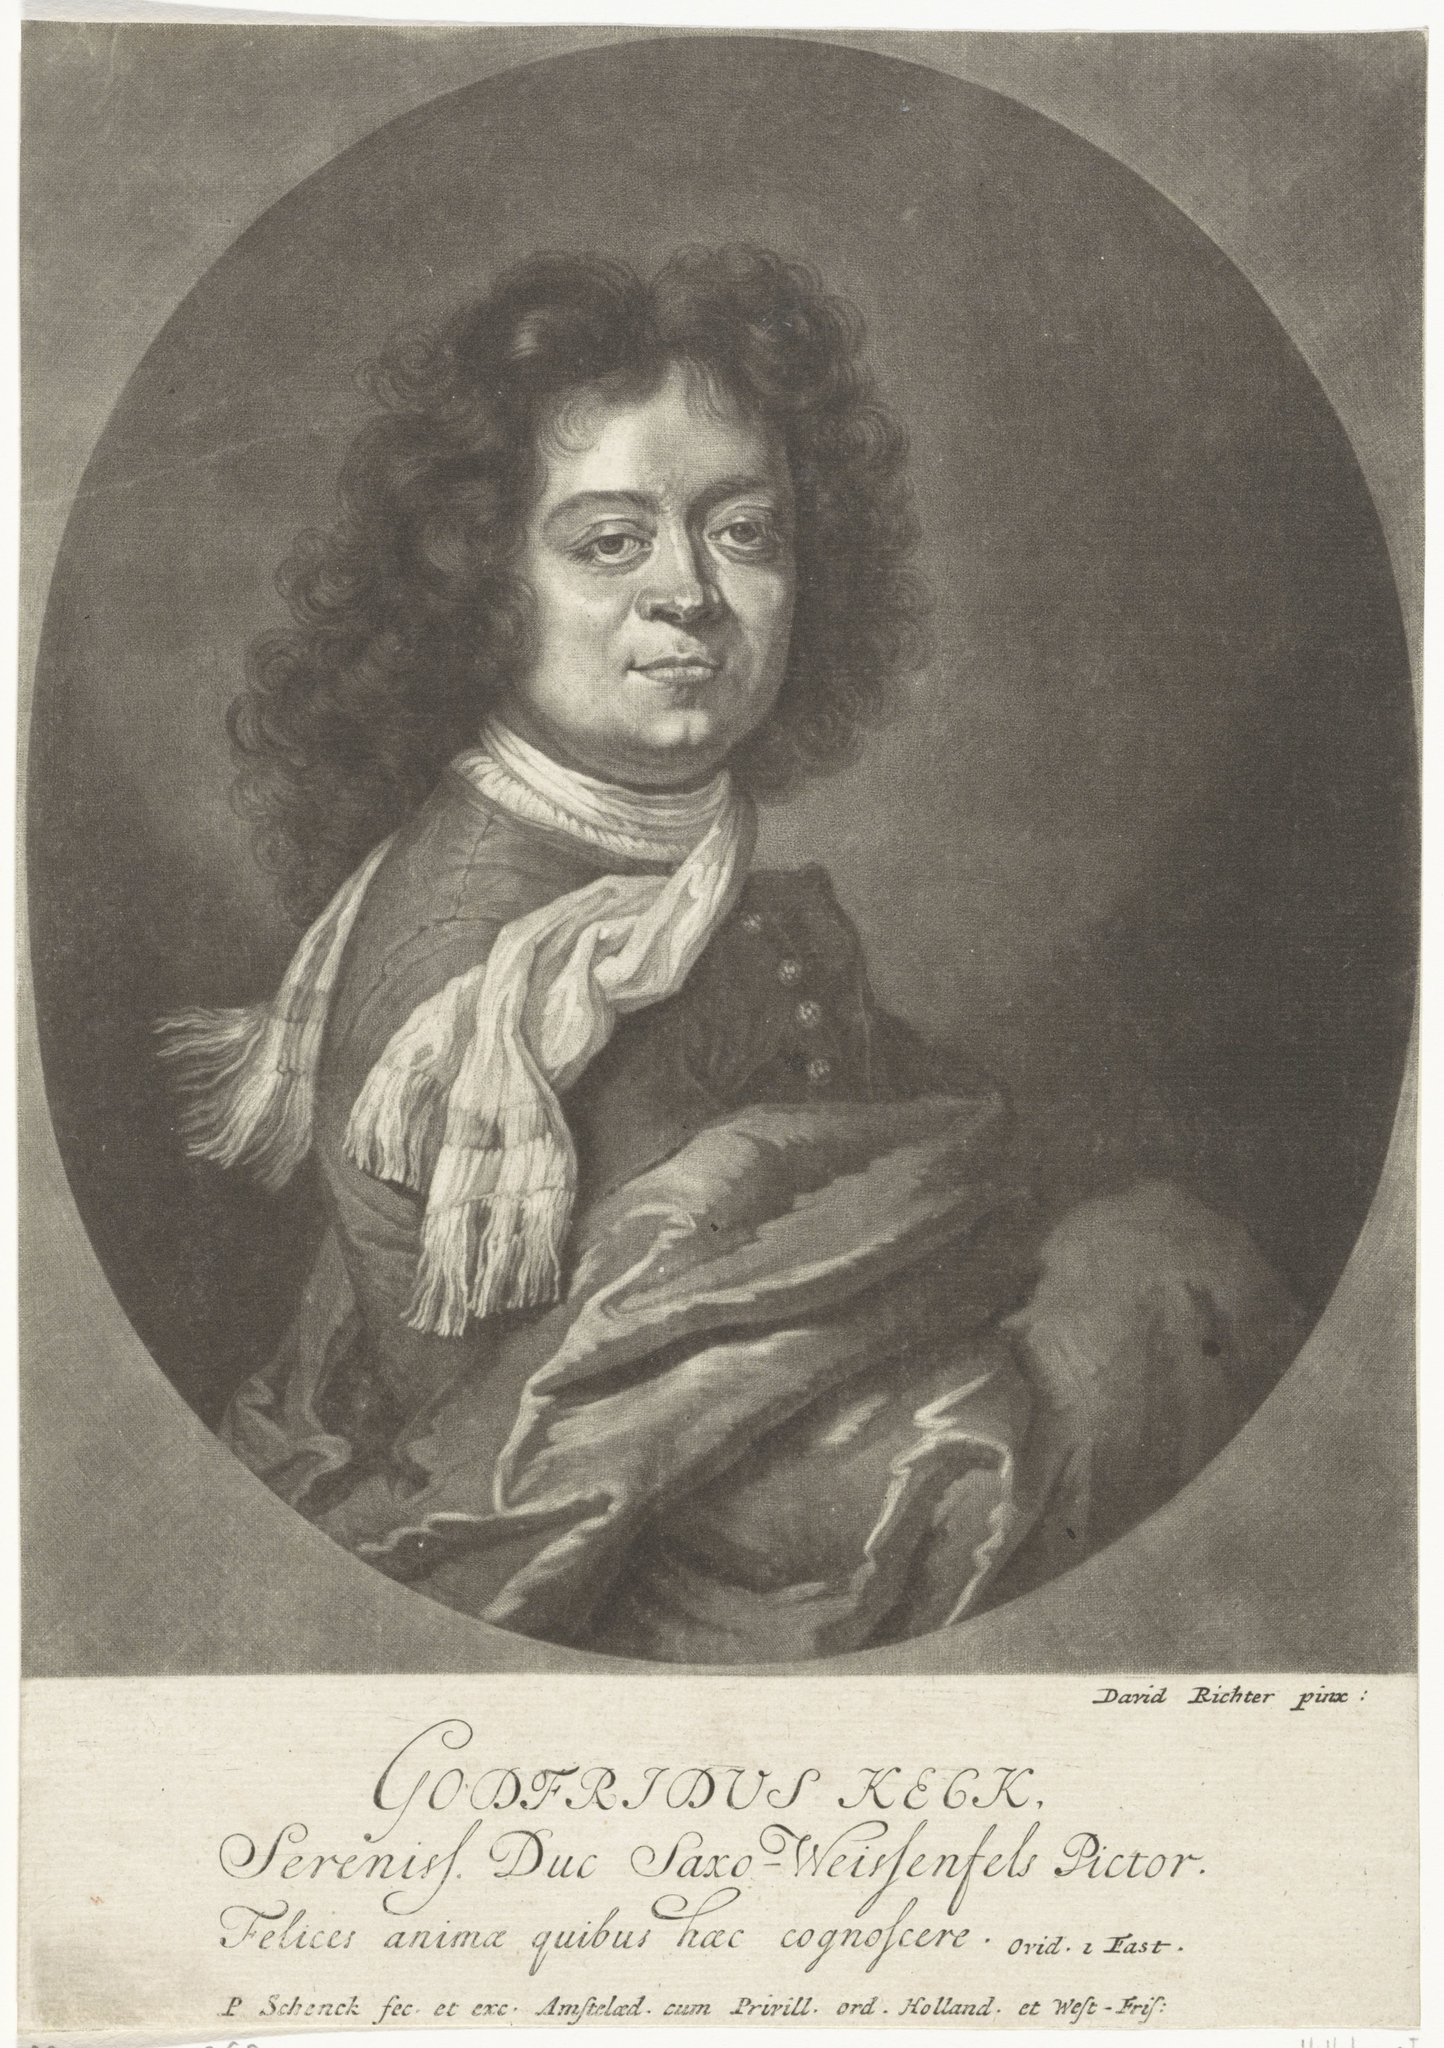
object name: print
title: Portret van de hofschilder Gottfried Keck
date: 1670-1713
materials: paper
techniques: engraving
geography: amsterdam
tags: portrait, self-portrait of painter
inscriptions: collector's mark: Lugt 2228